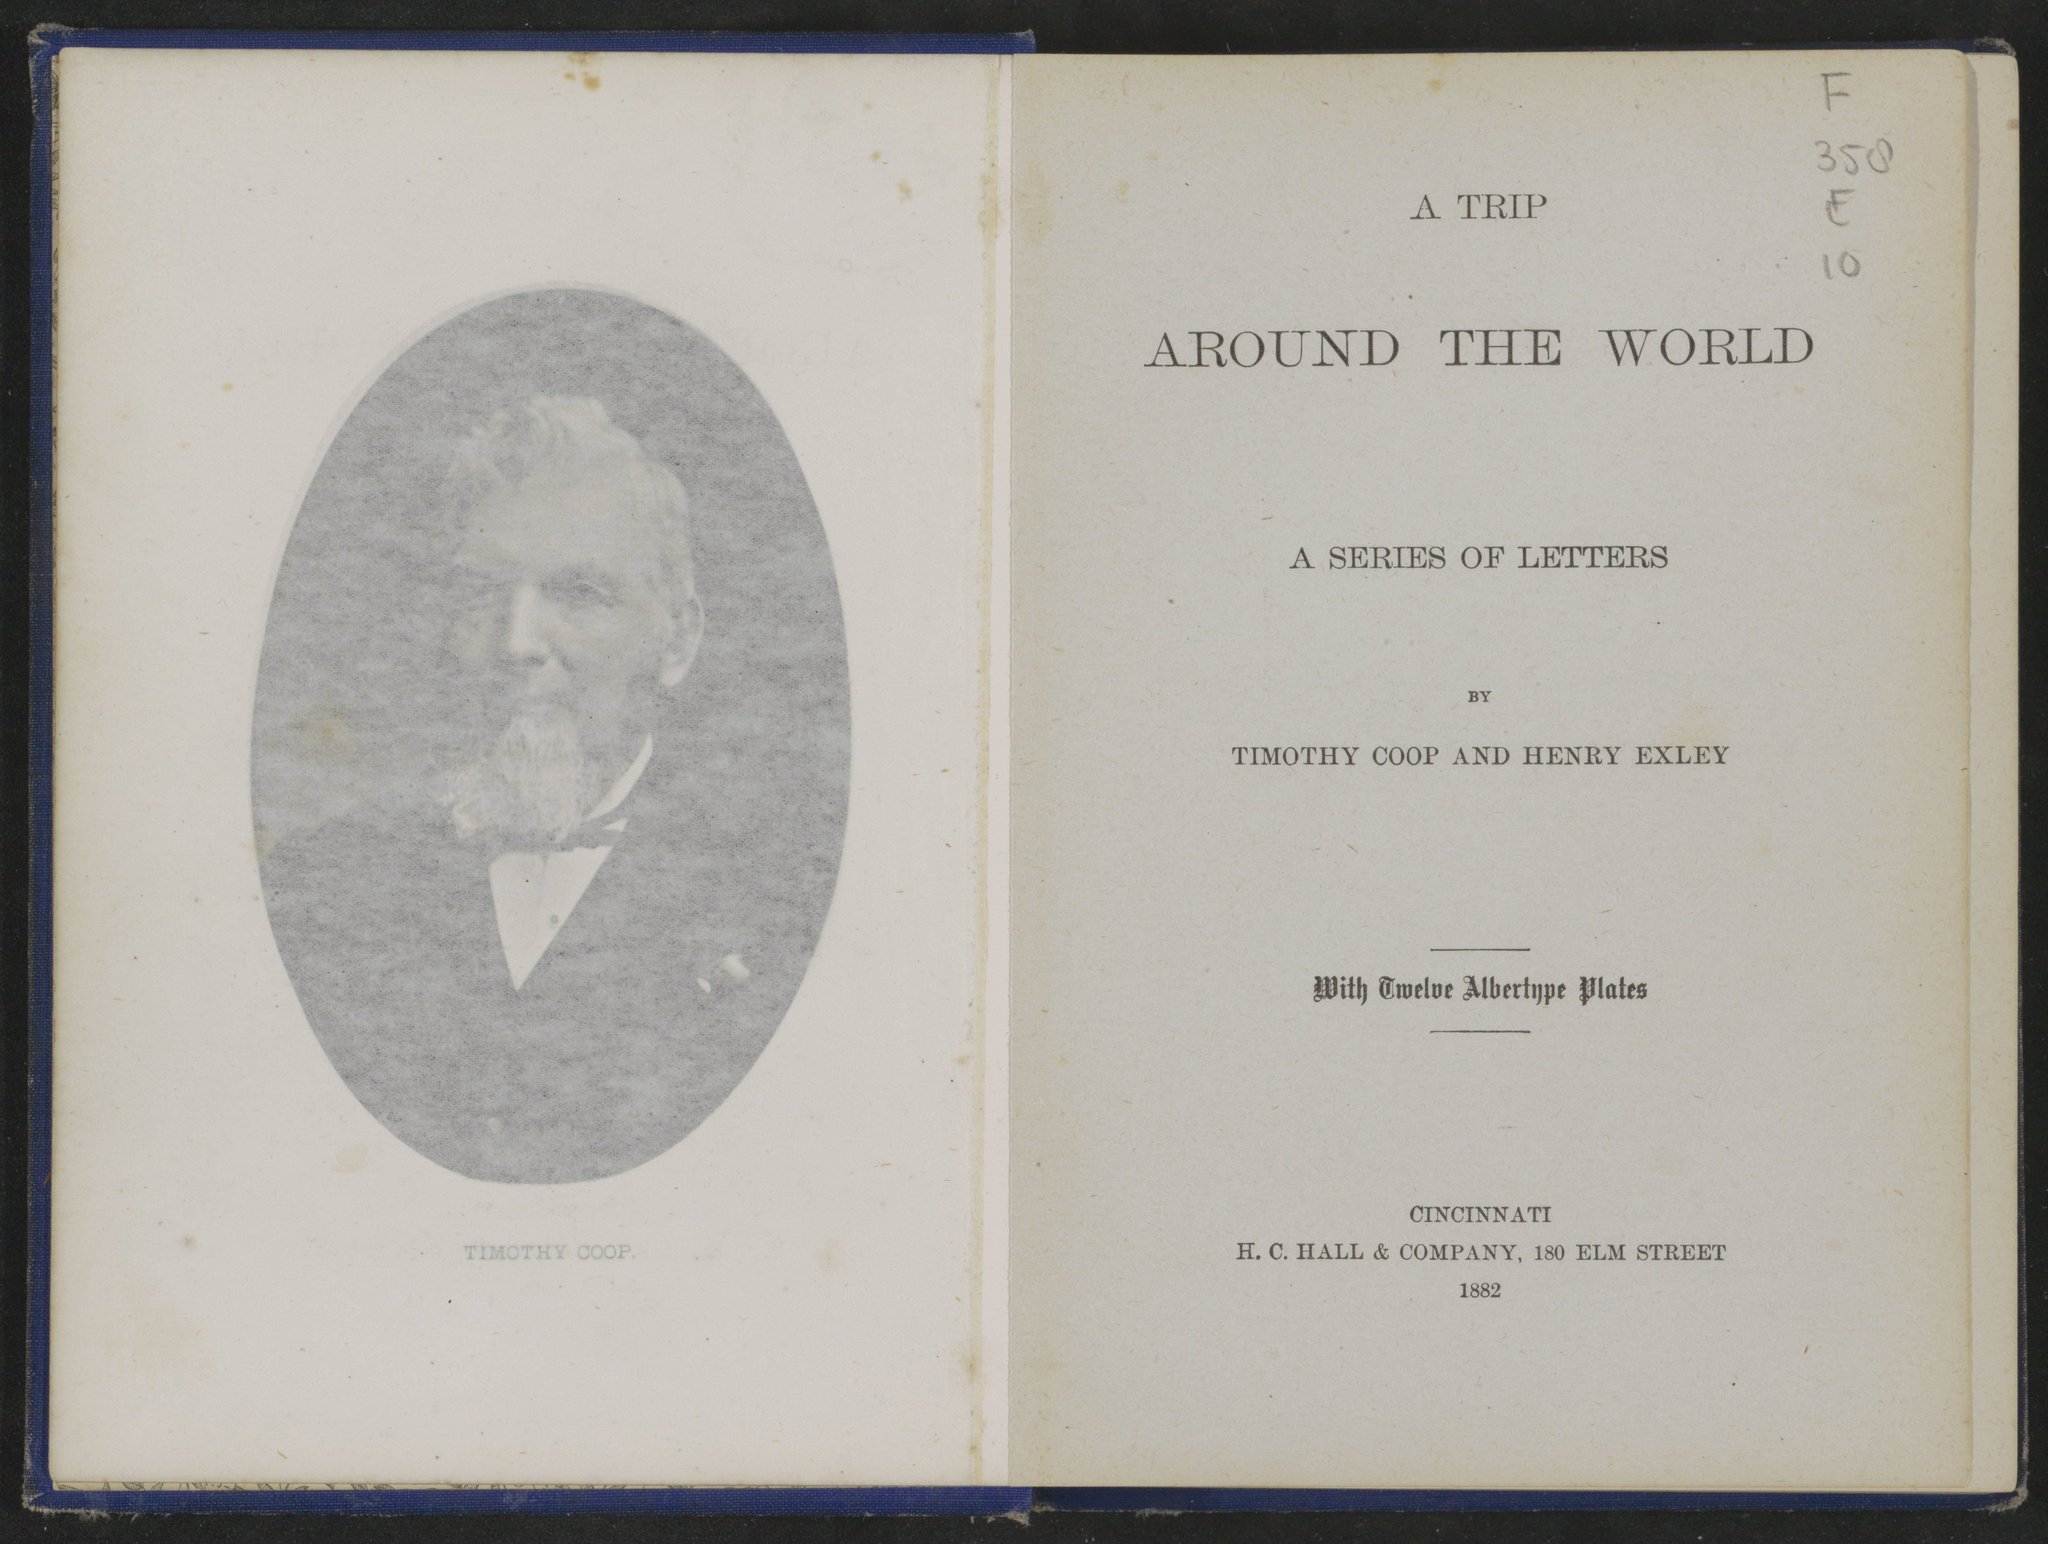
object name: book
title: A trip around the world: a series of letters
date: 1882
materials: cardboard, linen, paper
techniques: photograph, printing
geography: cincinnati